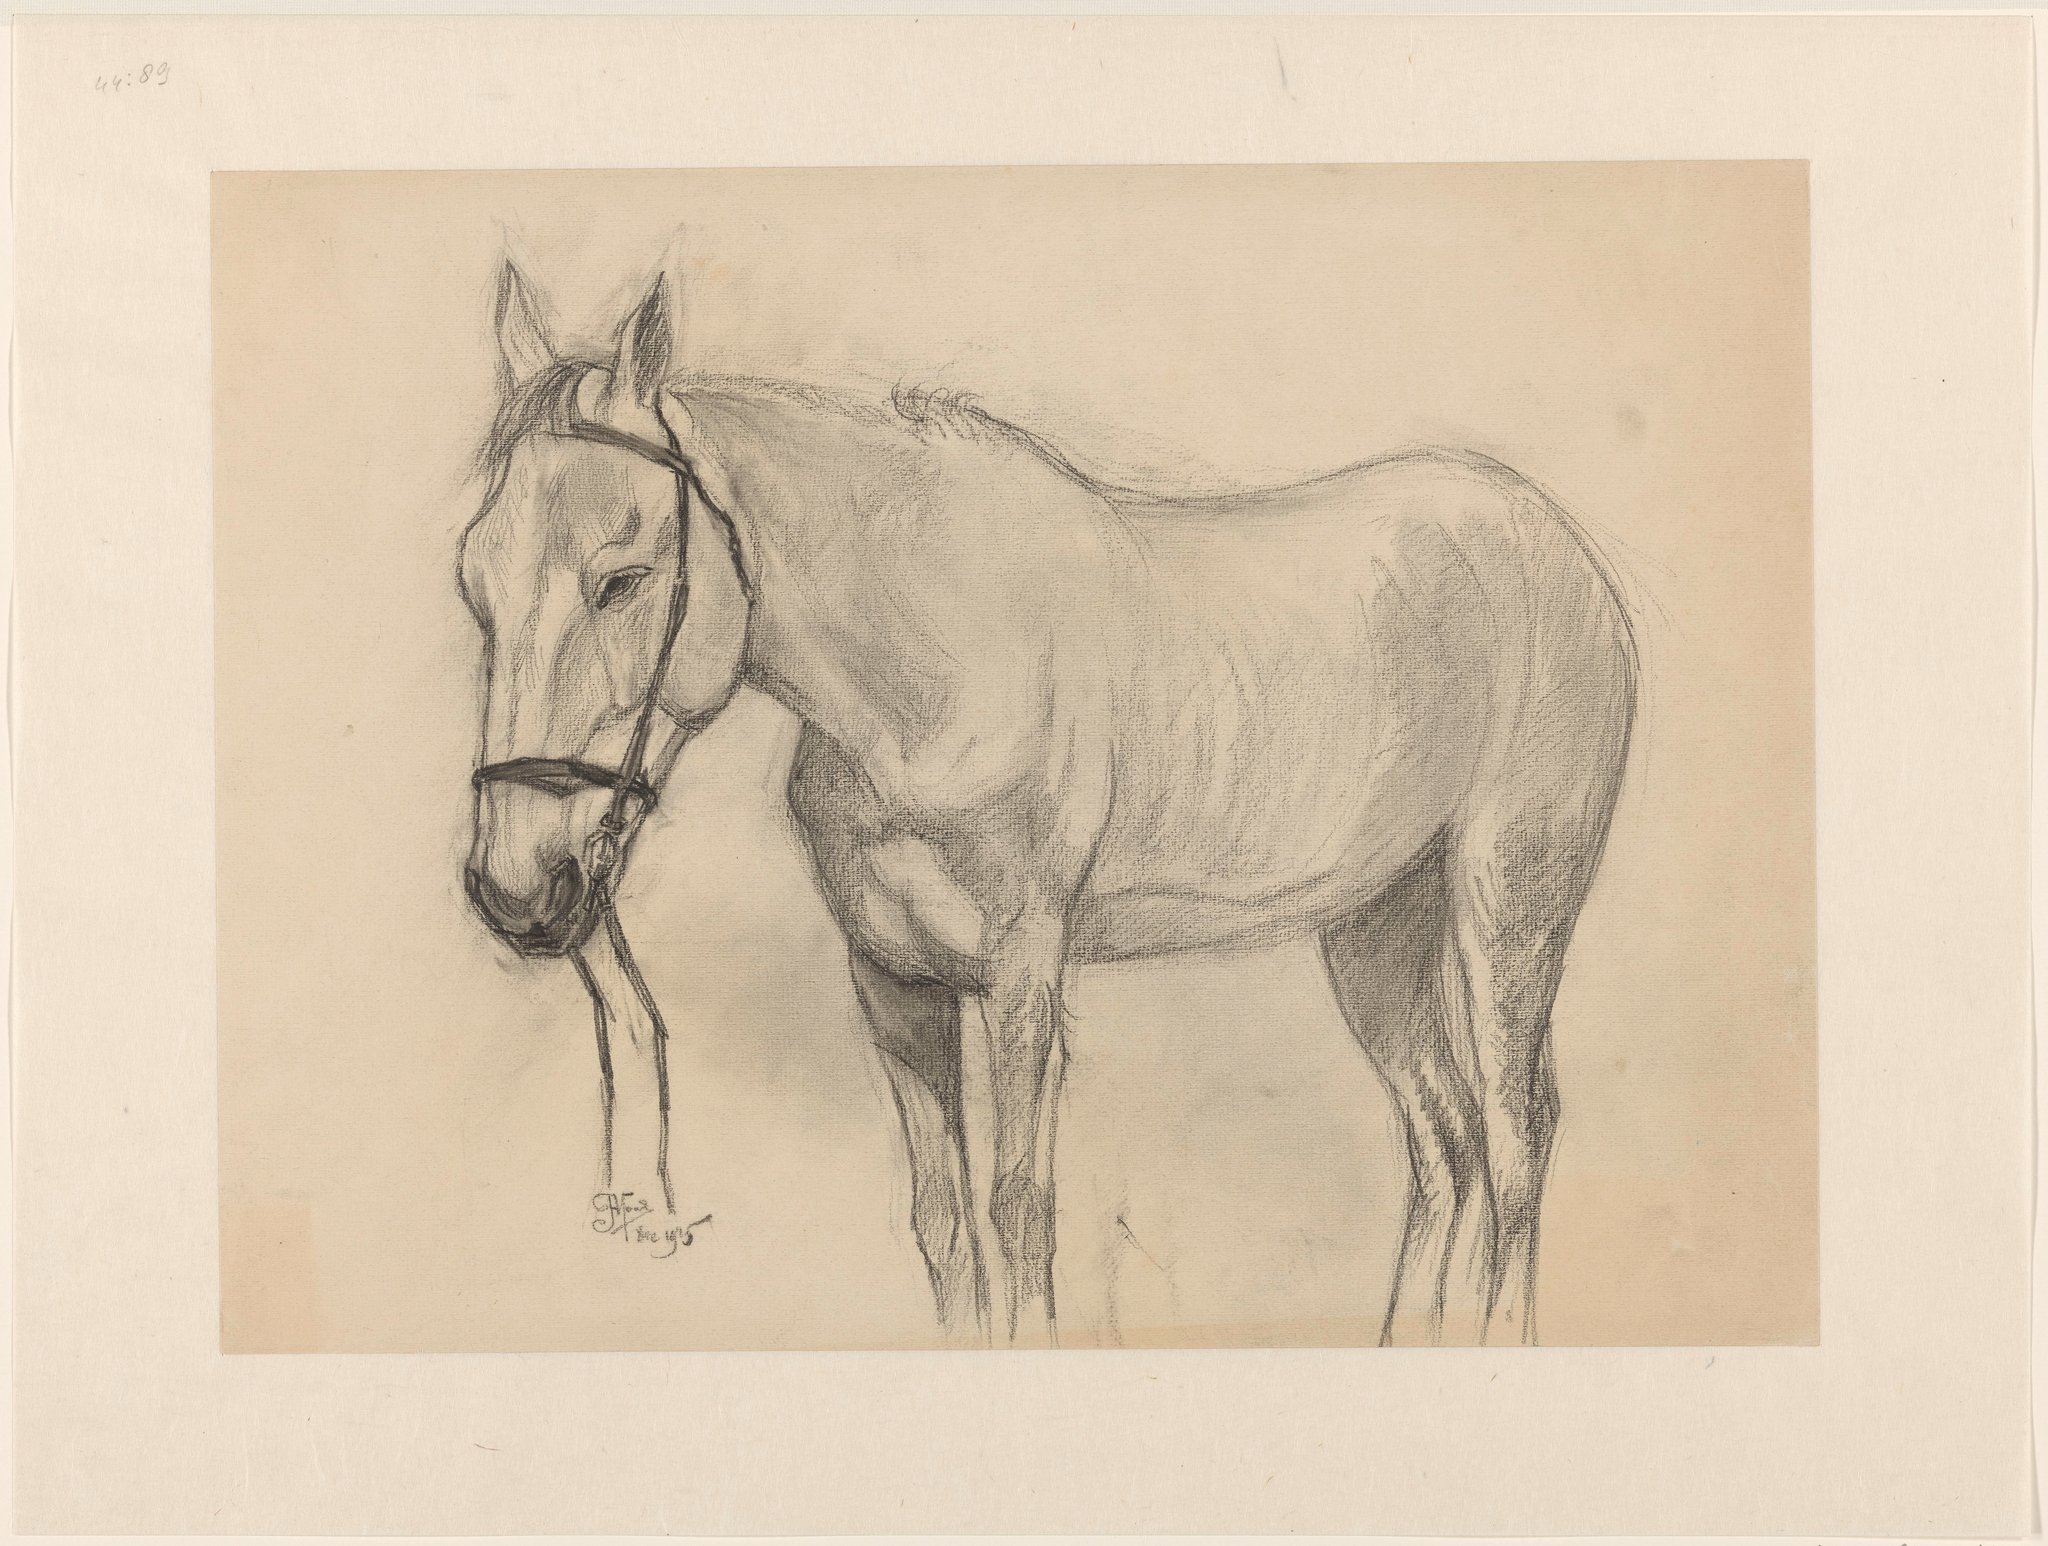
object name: drawing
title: Staand paard, naar links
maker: johannes abraham mondt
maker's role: draughtsman, print maker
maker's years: 1859-1941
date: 1912-1915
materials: chalk, paper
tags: horse